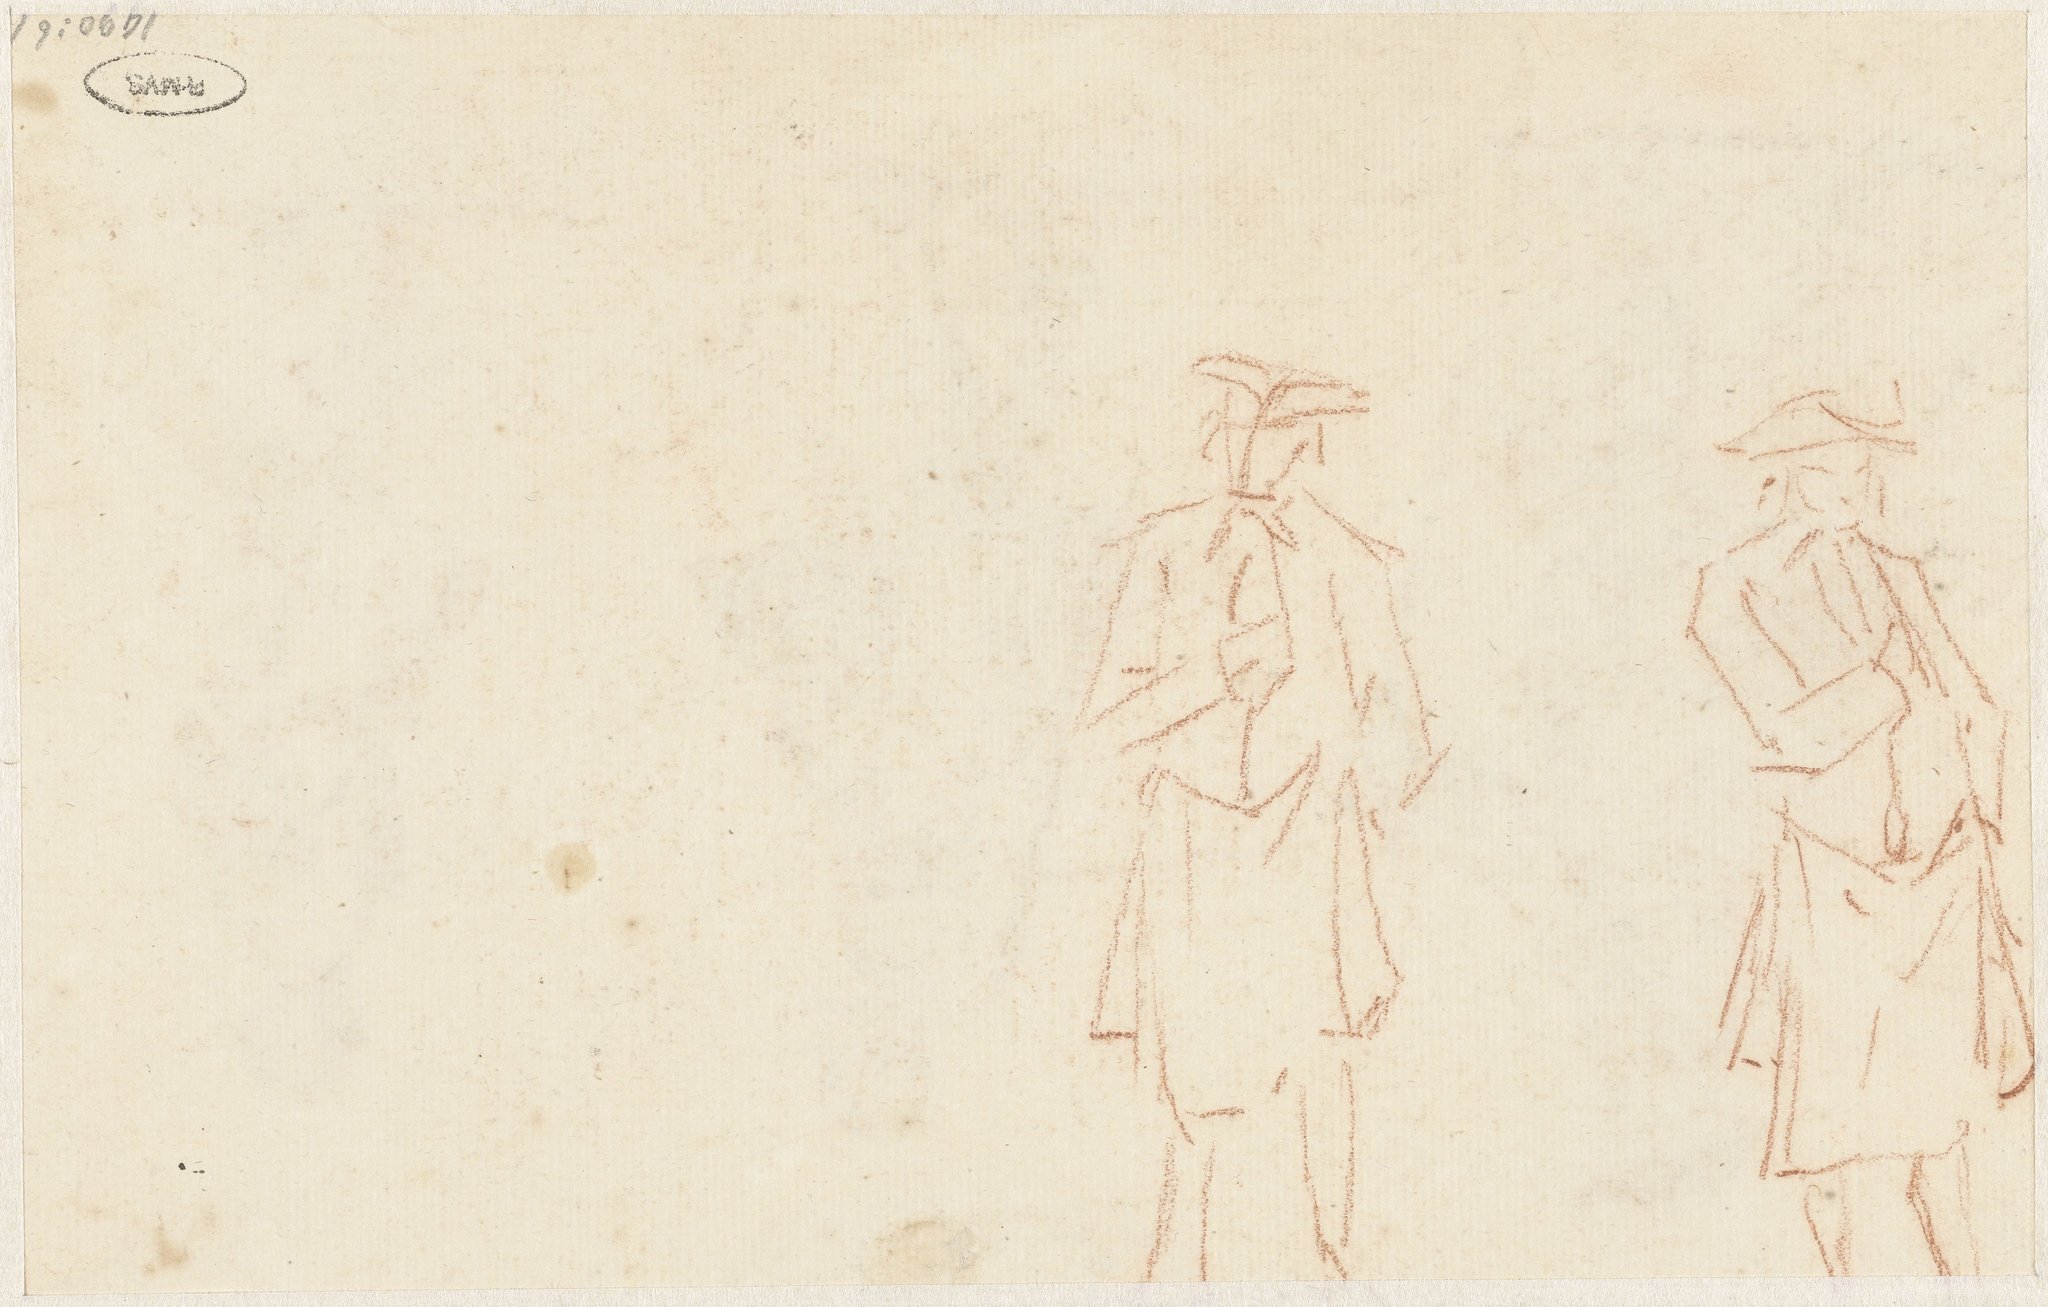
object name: drawing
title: Twee mannelijke figuren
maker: cornelis troost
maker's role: draughtsman, painter, print maker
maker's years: 1696-1750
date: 1706-1750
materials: chalk, paper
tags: postures of the human figure